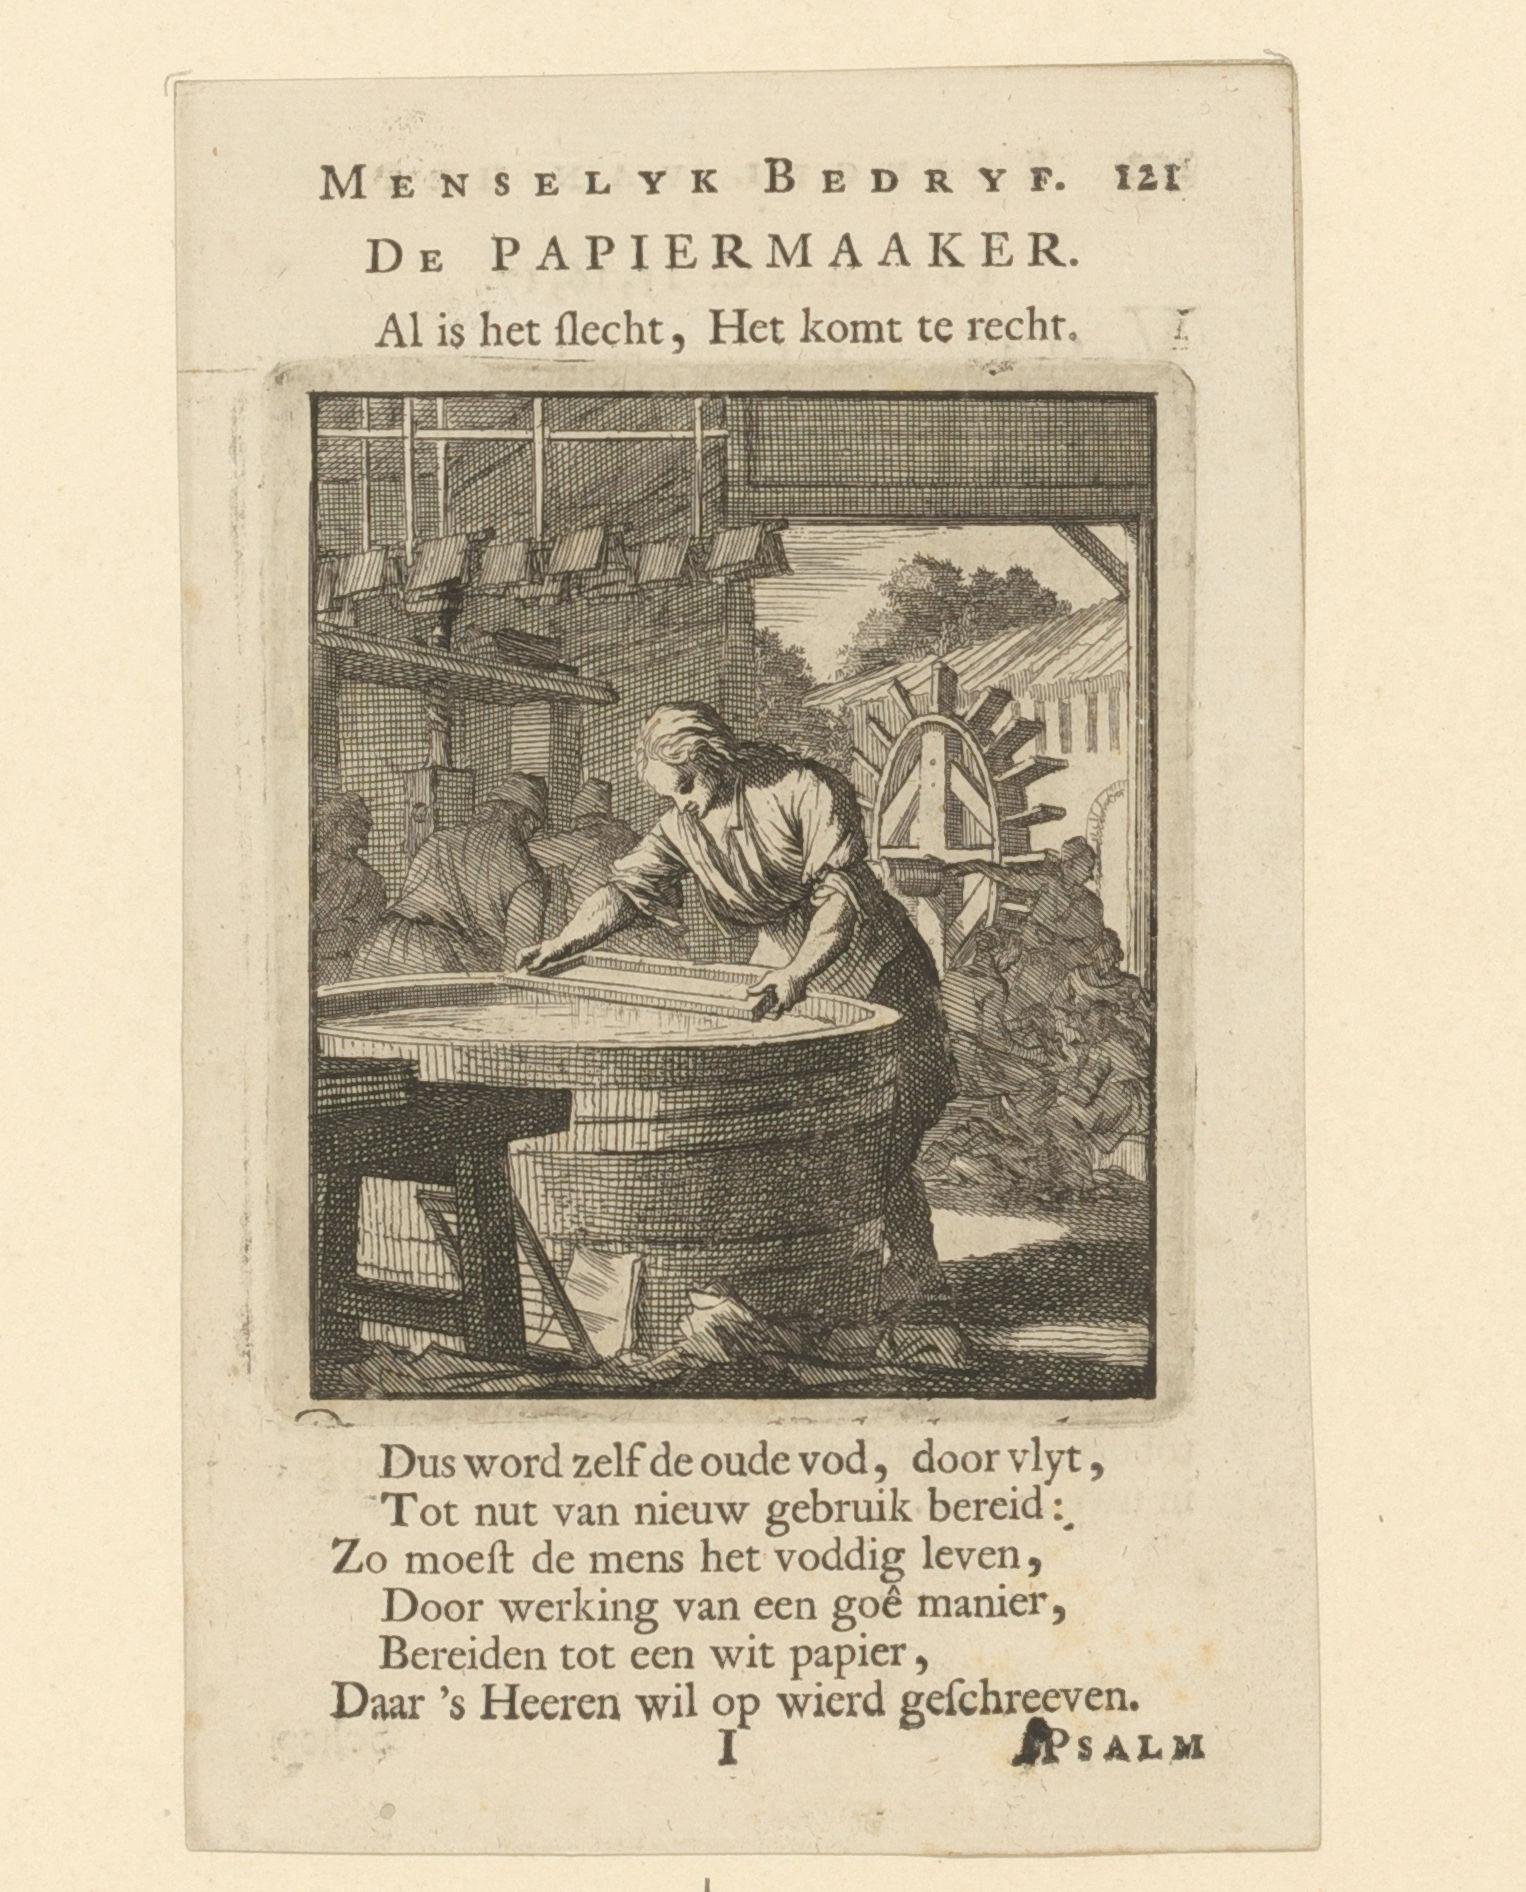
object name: book illustration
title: De Papiermaaker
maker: cornelis van der sys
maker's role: publisher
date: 1718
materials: paper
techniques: etching, letterpress printing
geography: amsterdam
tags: handicrafts, craftsman at work, paper (writing material)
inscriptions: stamp, stamp, collector's mark: Lugt 1641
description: Prent oorspronkelijk verschenen in de 100-delige serie beroepsprenten van Jan en Caspar Luyken, getiteld: Het menselyk bedryf. S.l.s.n., 1694 (eerste druk). Daarna is de titel en het vers afgesneden. De prenten in diverse publicaties verschenen en gekopieerd. Huidige staat uit: Luyken, Jan en Caspar. Spiegel van het menselyk bedryf (...). Amsterdam: Cornelis van der Sys, 1718, p. 121. Prent waarschijnlijk ook gebruikt in eerdere (1704) en latere (1730, 1749, 1767) publicaties.